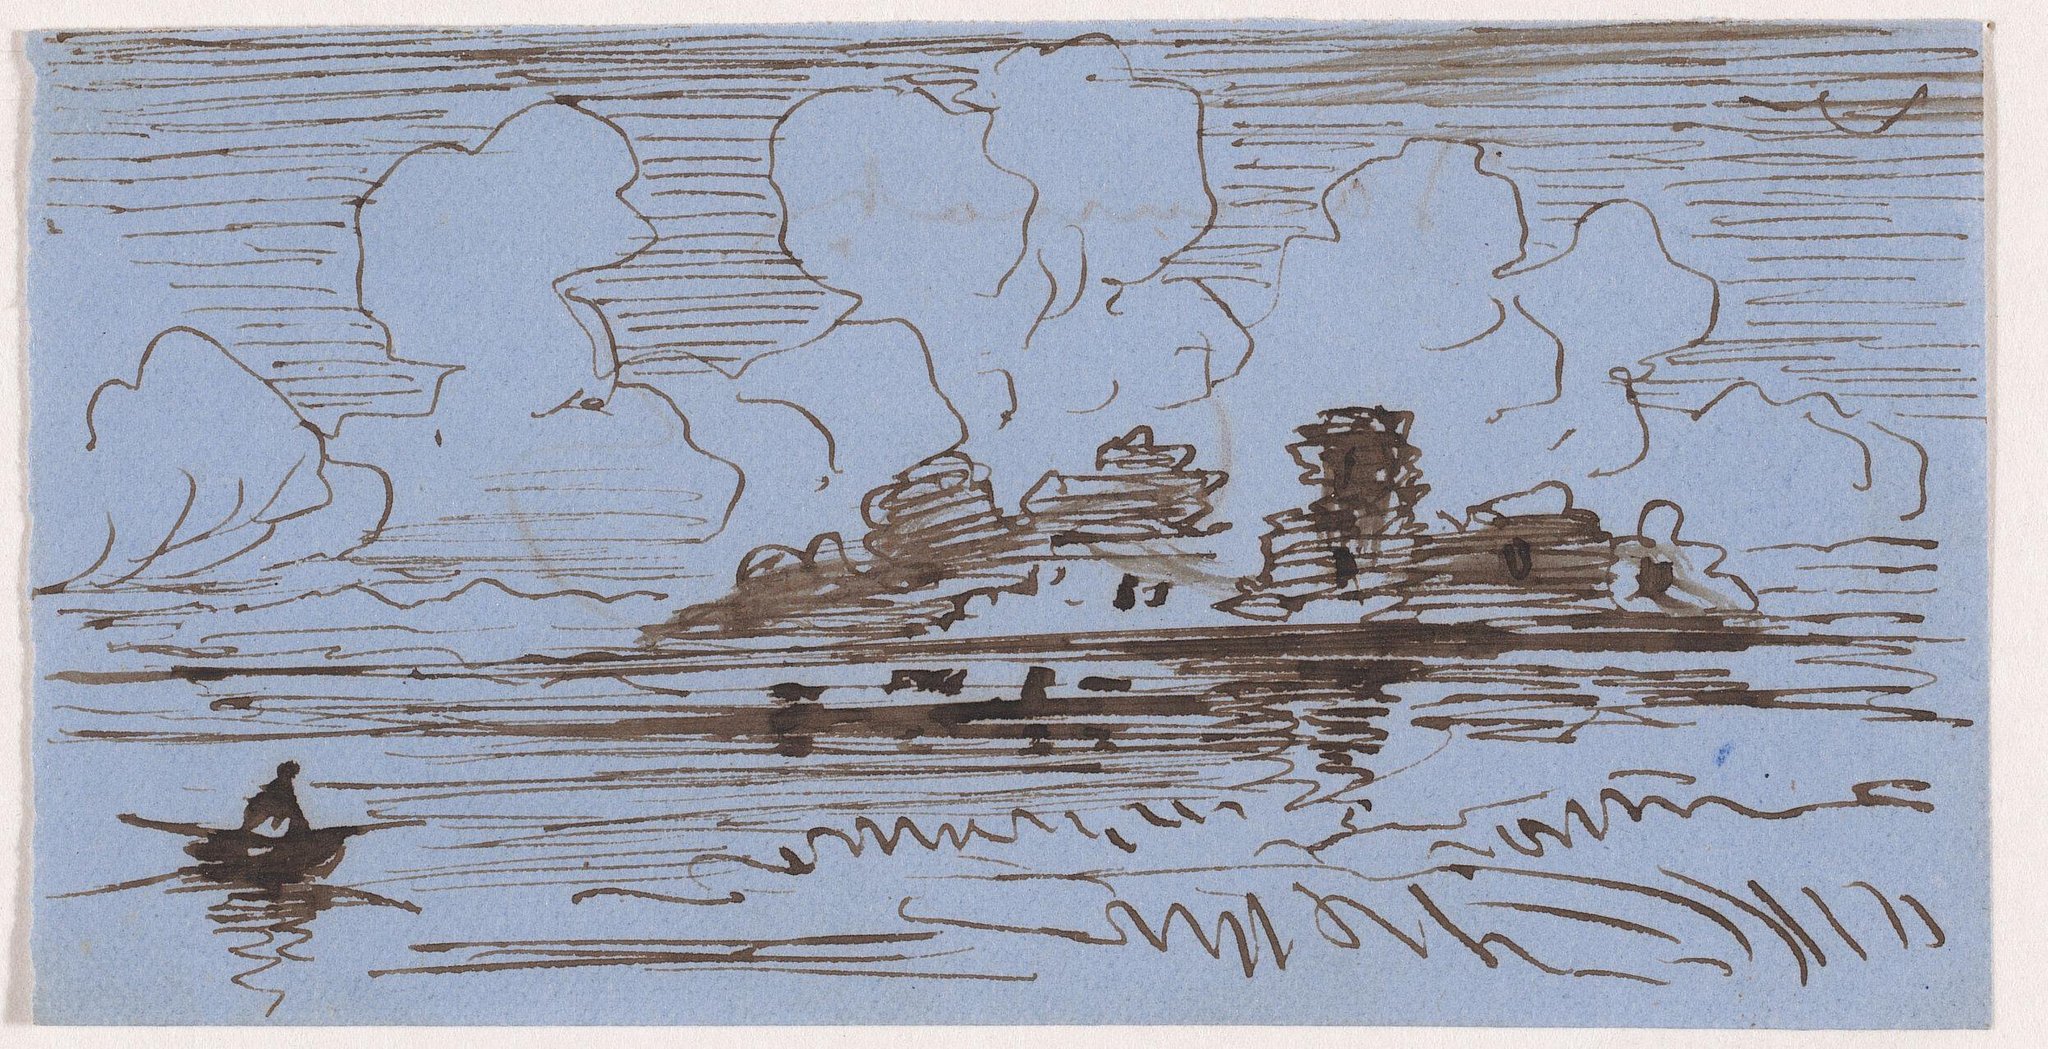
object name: drawing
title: Rivierlandschap met roeibootje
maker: johannes tavenraat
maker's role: draughtsman, painter, print maker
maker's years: 1809-1881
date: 1840-1880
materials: ink, paper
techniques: pen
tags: river (+ landscape with figures, staffage)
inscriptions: signature: ‘Tavenraat’, collector's mark: Lugt 2228